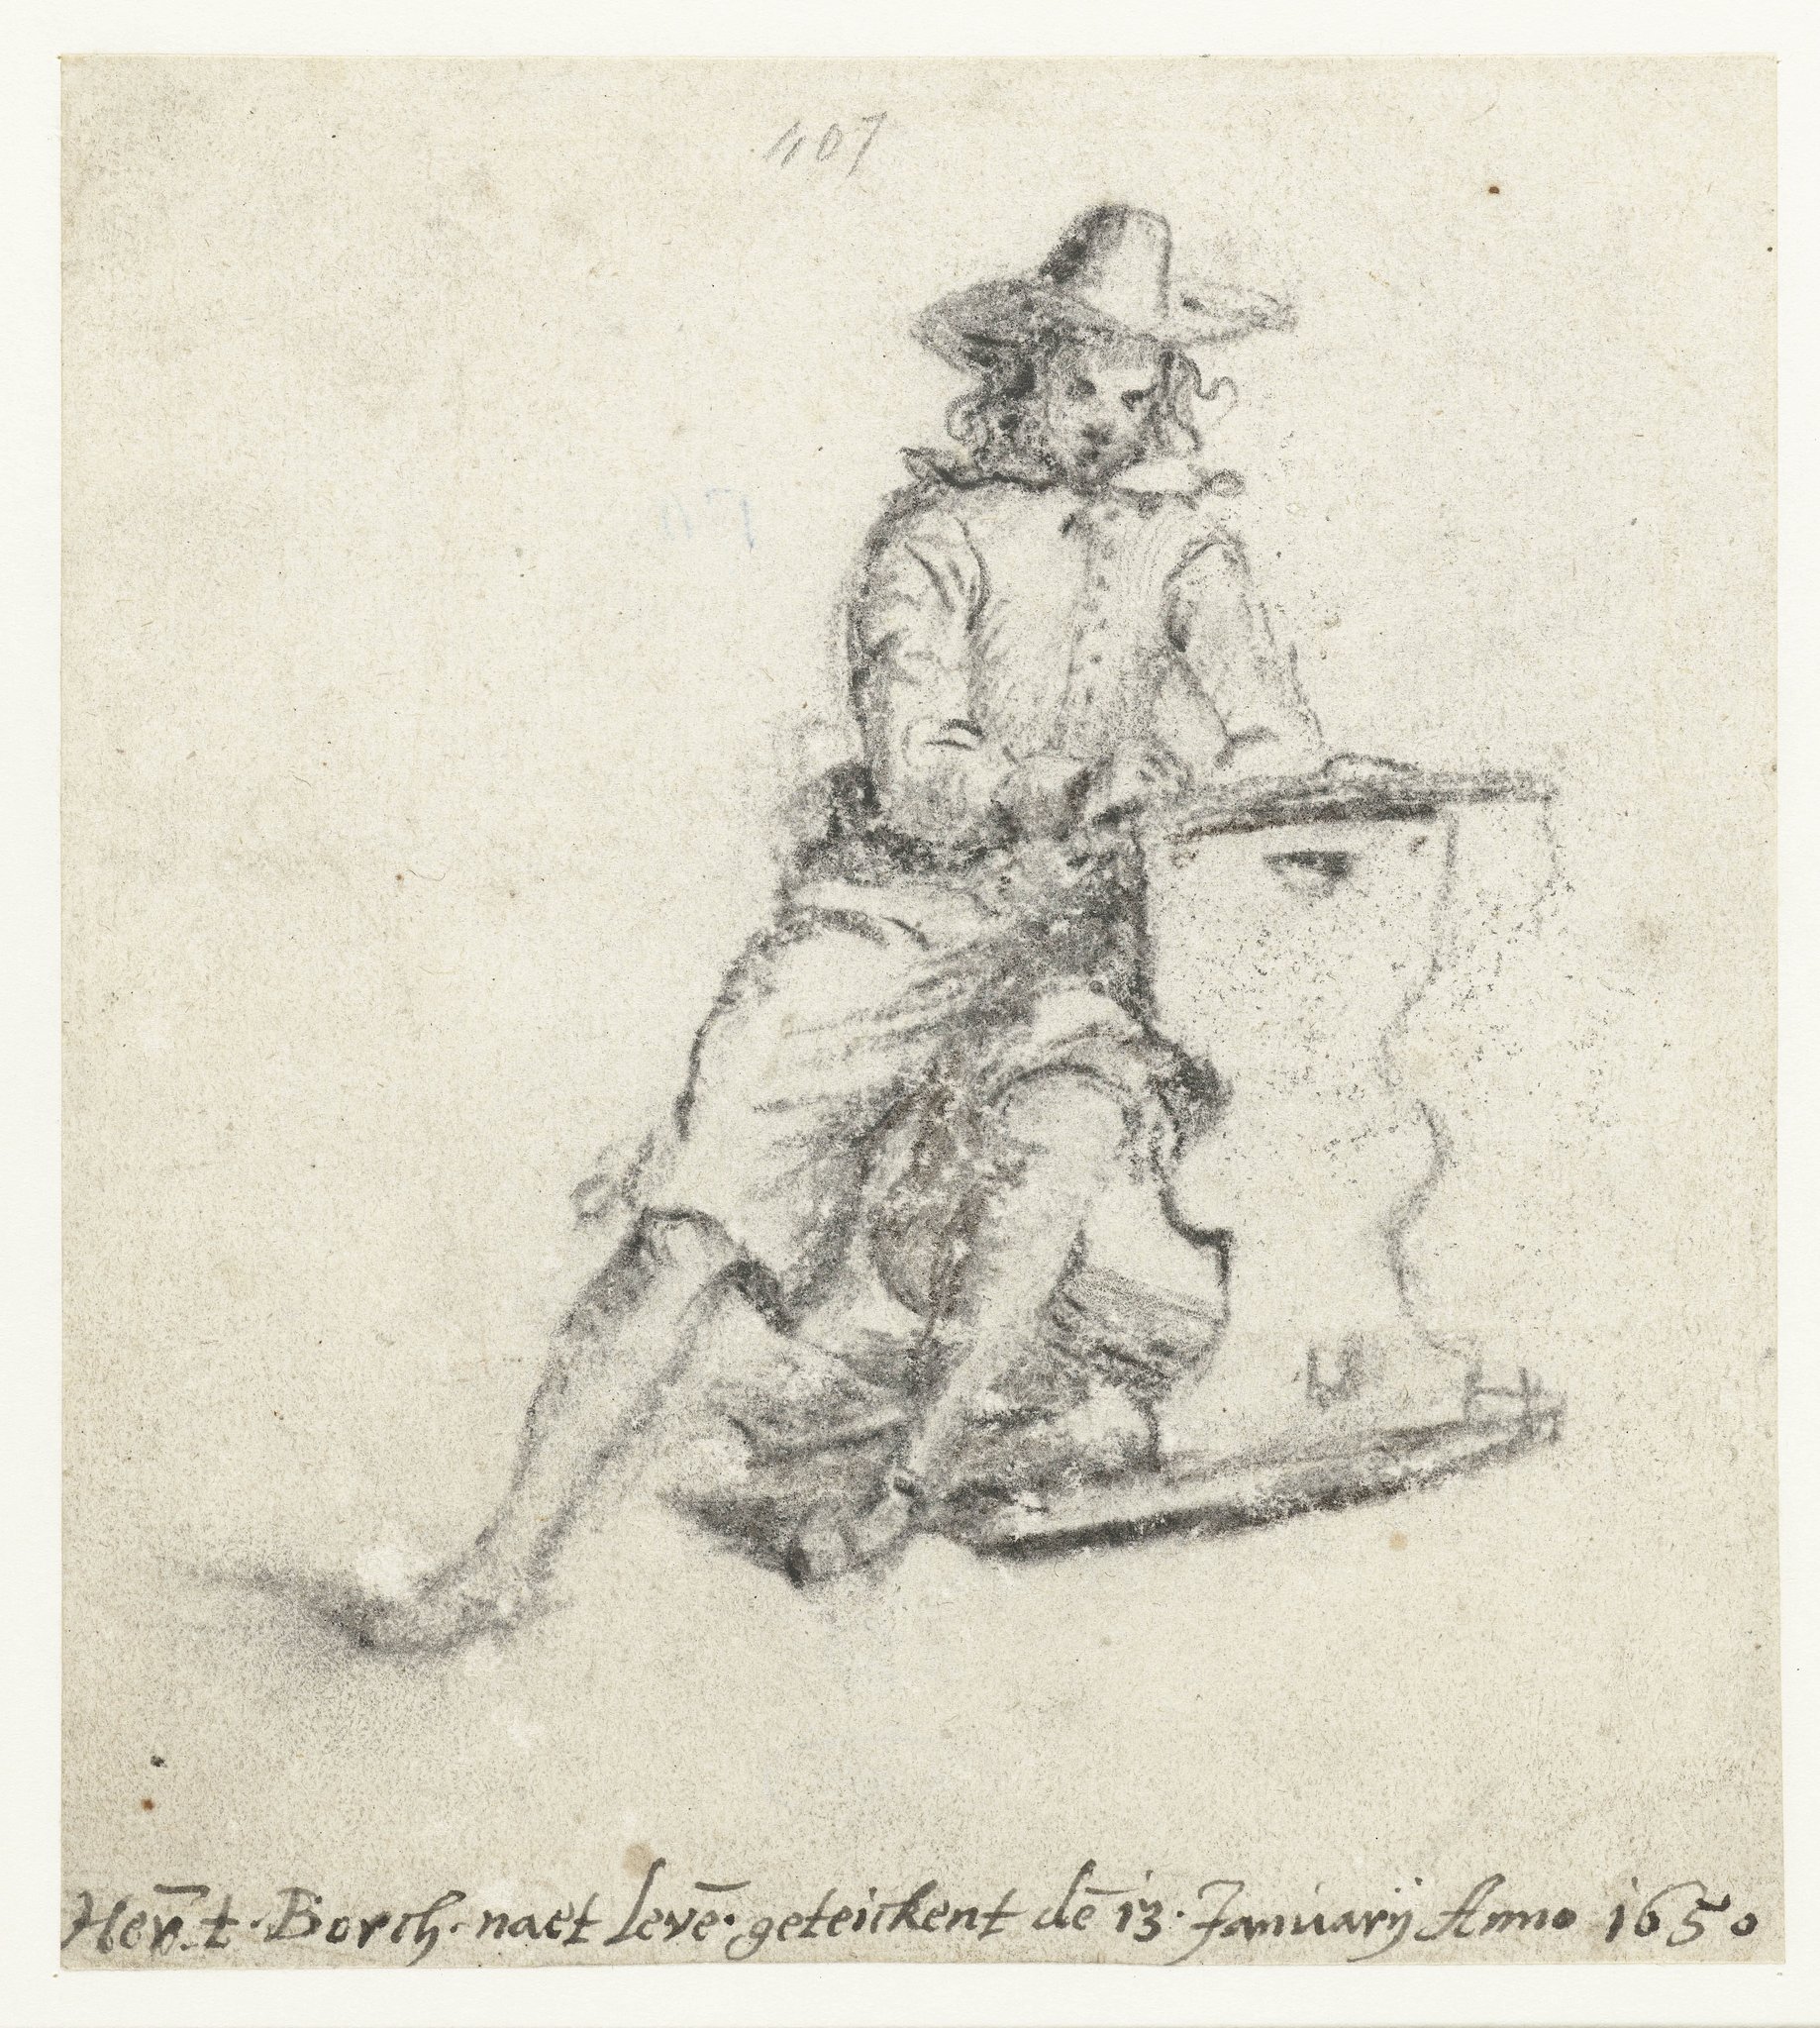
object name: drawing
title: Zittende, tekenende man (Gerard de Jonge?)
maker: harmen ter borch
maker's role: draughtsman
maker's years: 1638-1677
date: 1650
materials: chalk, paper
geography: zwolle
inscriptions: annotation: ‘Her[man].t.Borch. naet leve[n]. geteickent de[n] 13.Januarij Anno 1650’